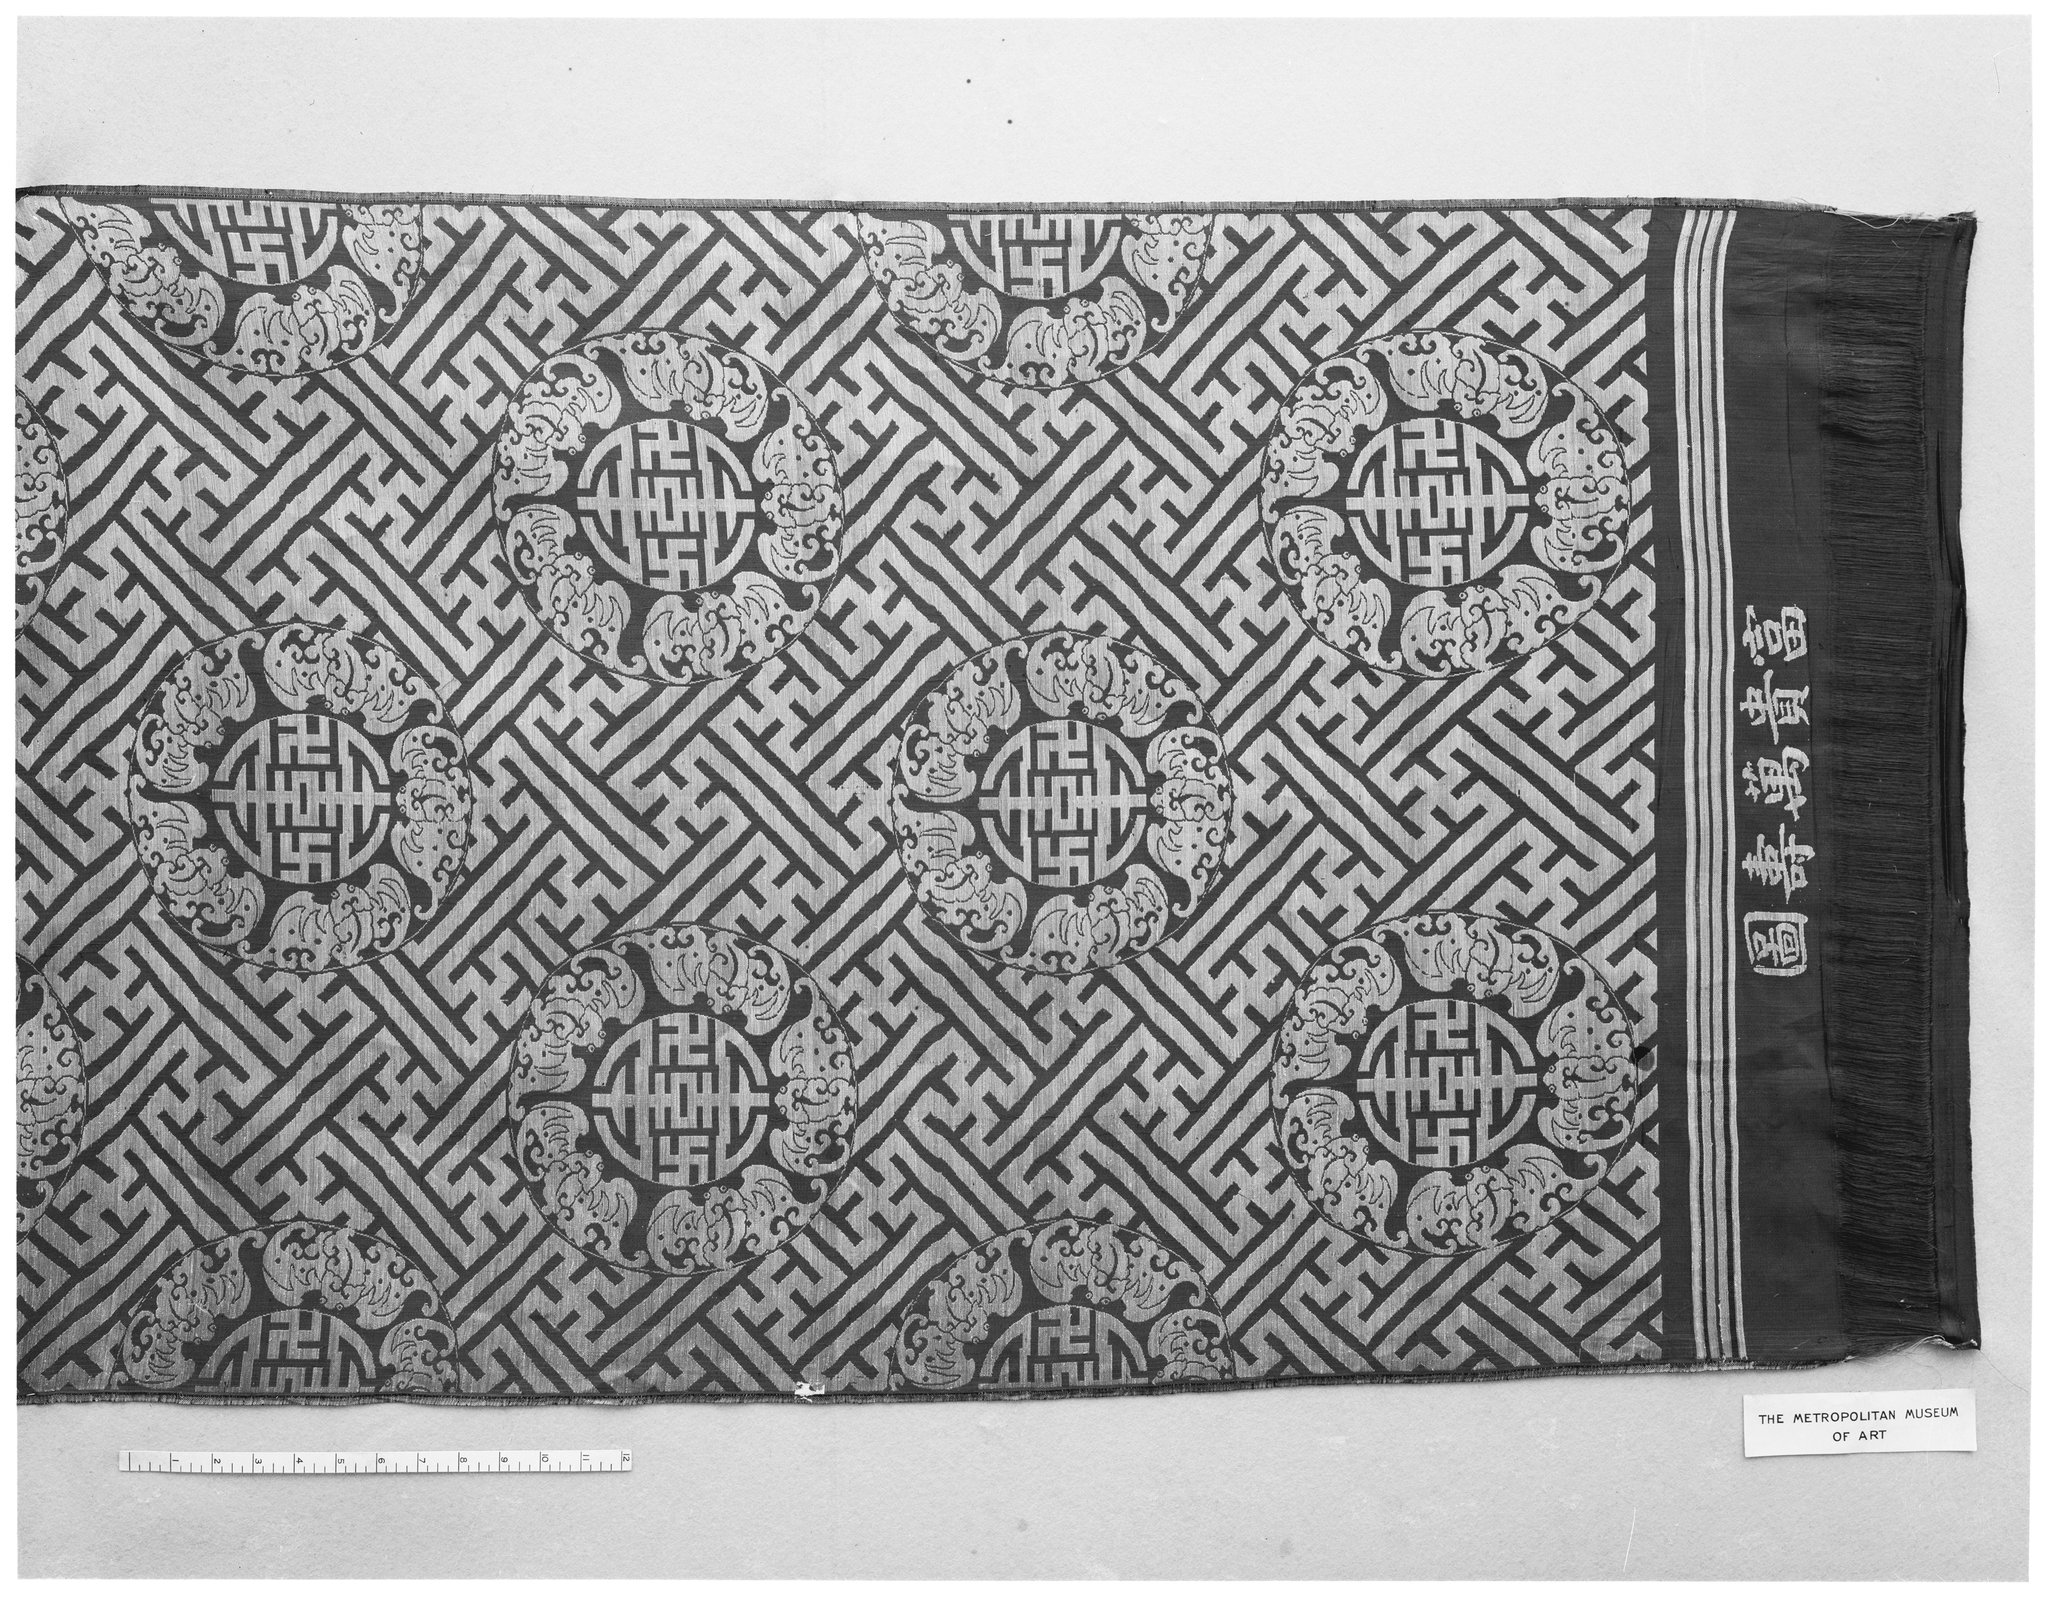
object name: length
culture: chinese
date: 1644-1911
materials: silk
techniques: weave